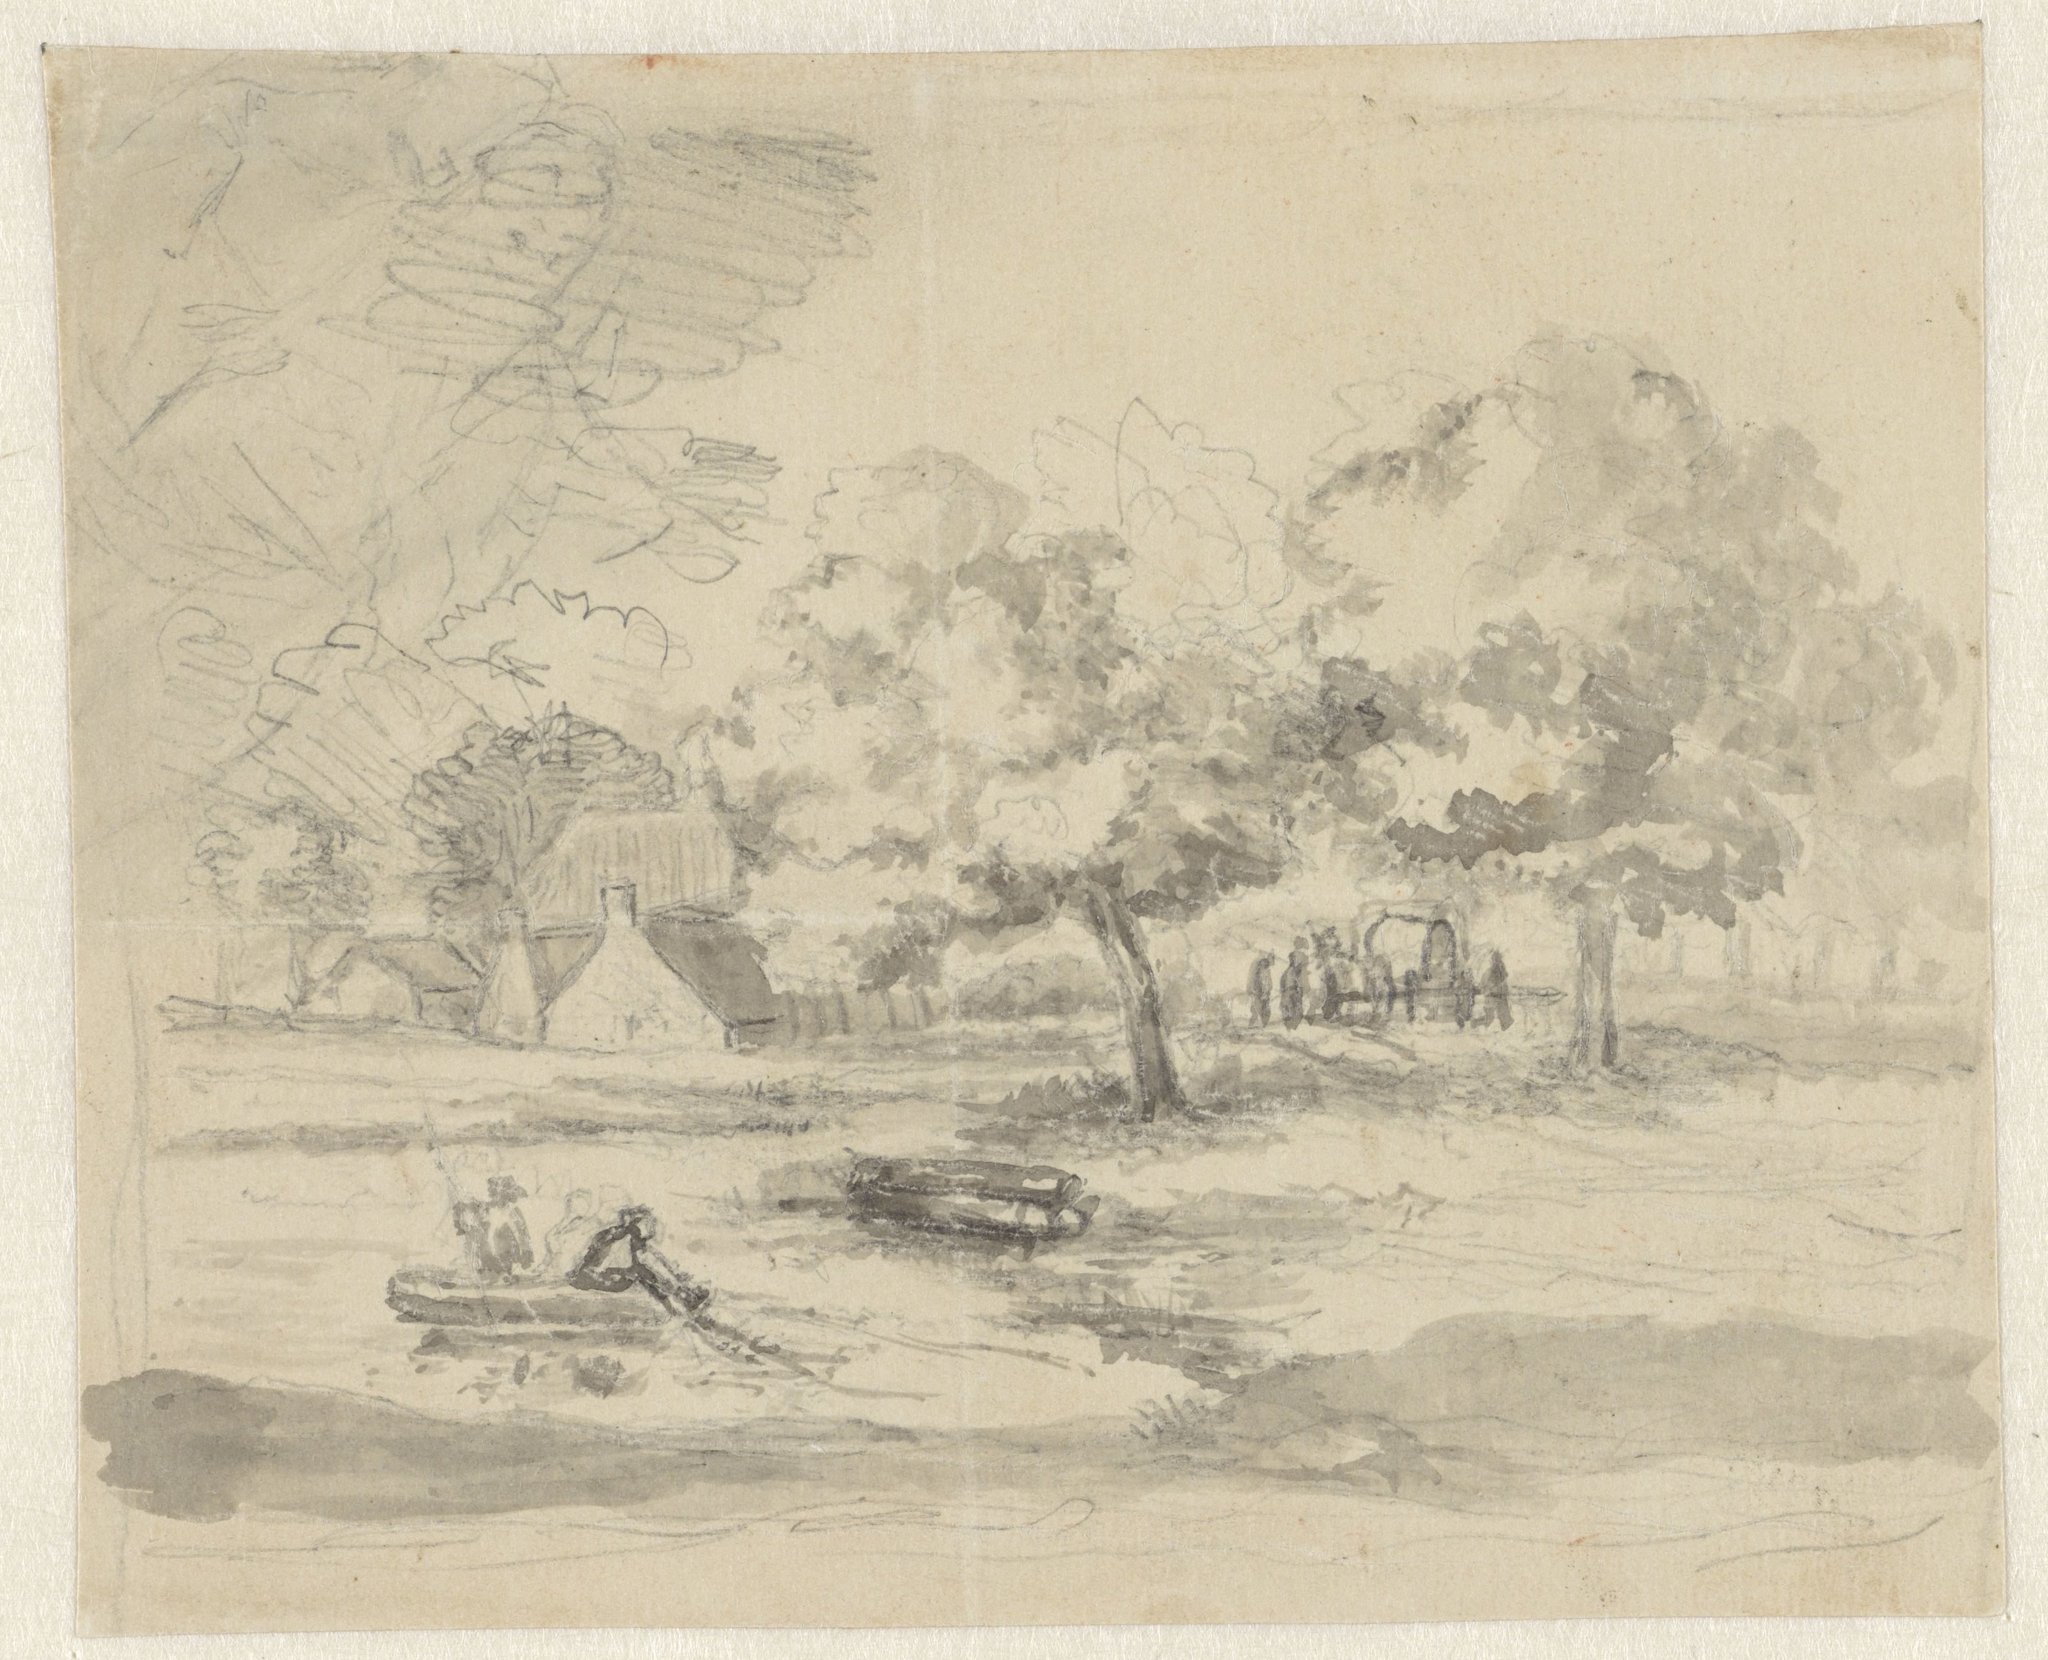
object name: drawing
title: Landschap met vissers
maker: david van der kellen (1827-1895)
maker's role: draughtsman, print maker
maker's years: 1827-1895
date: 1837-1895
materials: chalk, paper, pencil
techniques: brush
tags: farm or solitary house in landscape